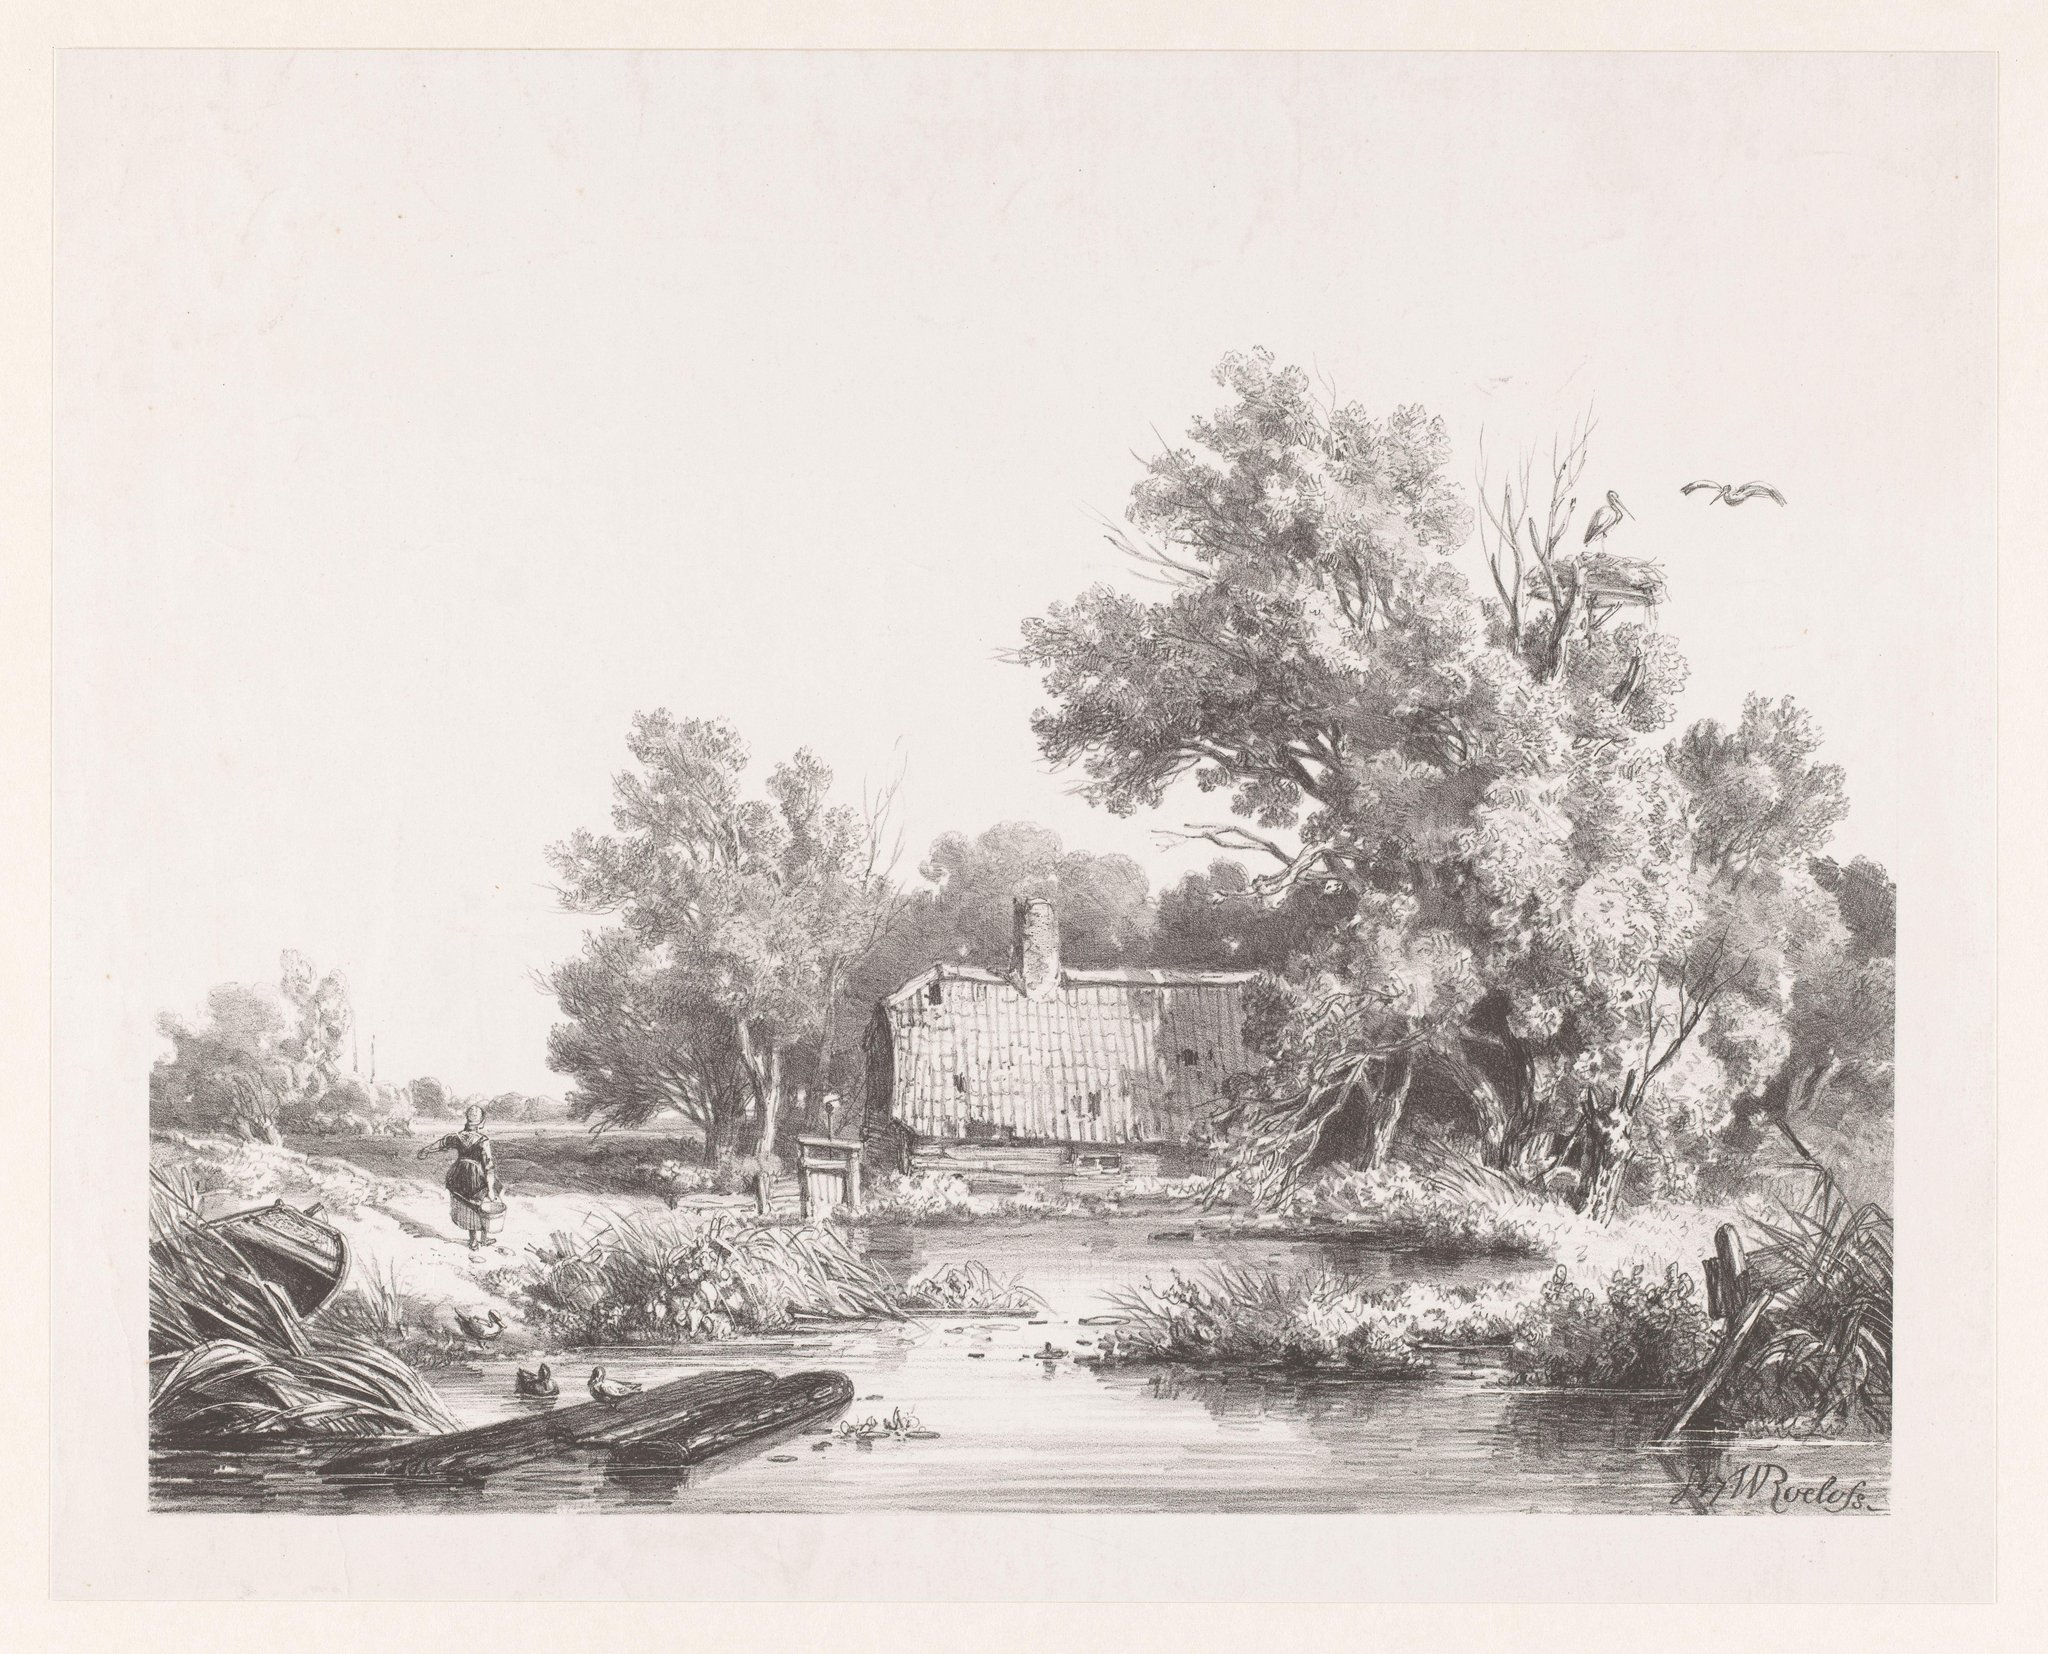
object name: print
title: Boerderij aan het water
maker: willem roelofs (i)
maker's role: draughtsman, painter, print maker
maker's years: 1822-1897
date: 1847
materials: paper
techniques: lithograph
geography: netherlands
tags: landscapes (+ landscape with figures, staffage), farm or solitary house in landscape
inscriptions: collector's mark: Lugt 2228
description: Een vrouw met emmer loopt in een landschap langs water waaraan een boerderij ligt.